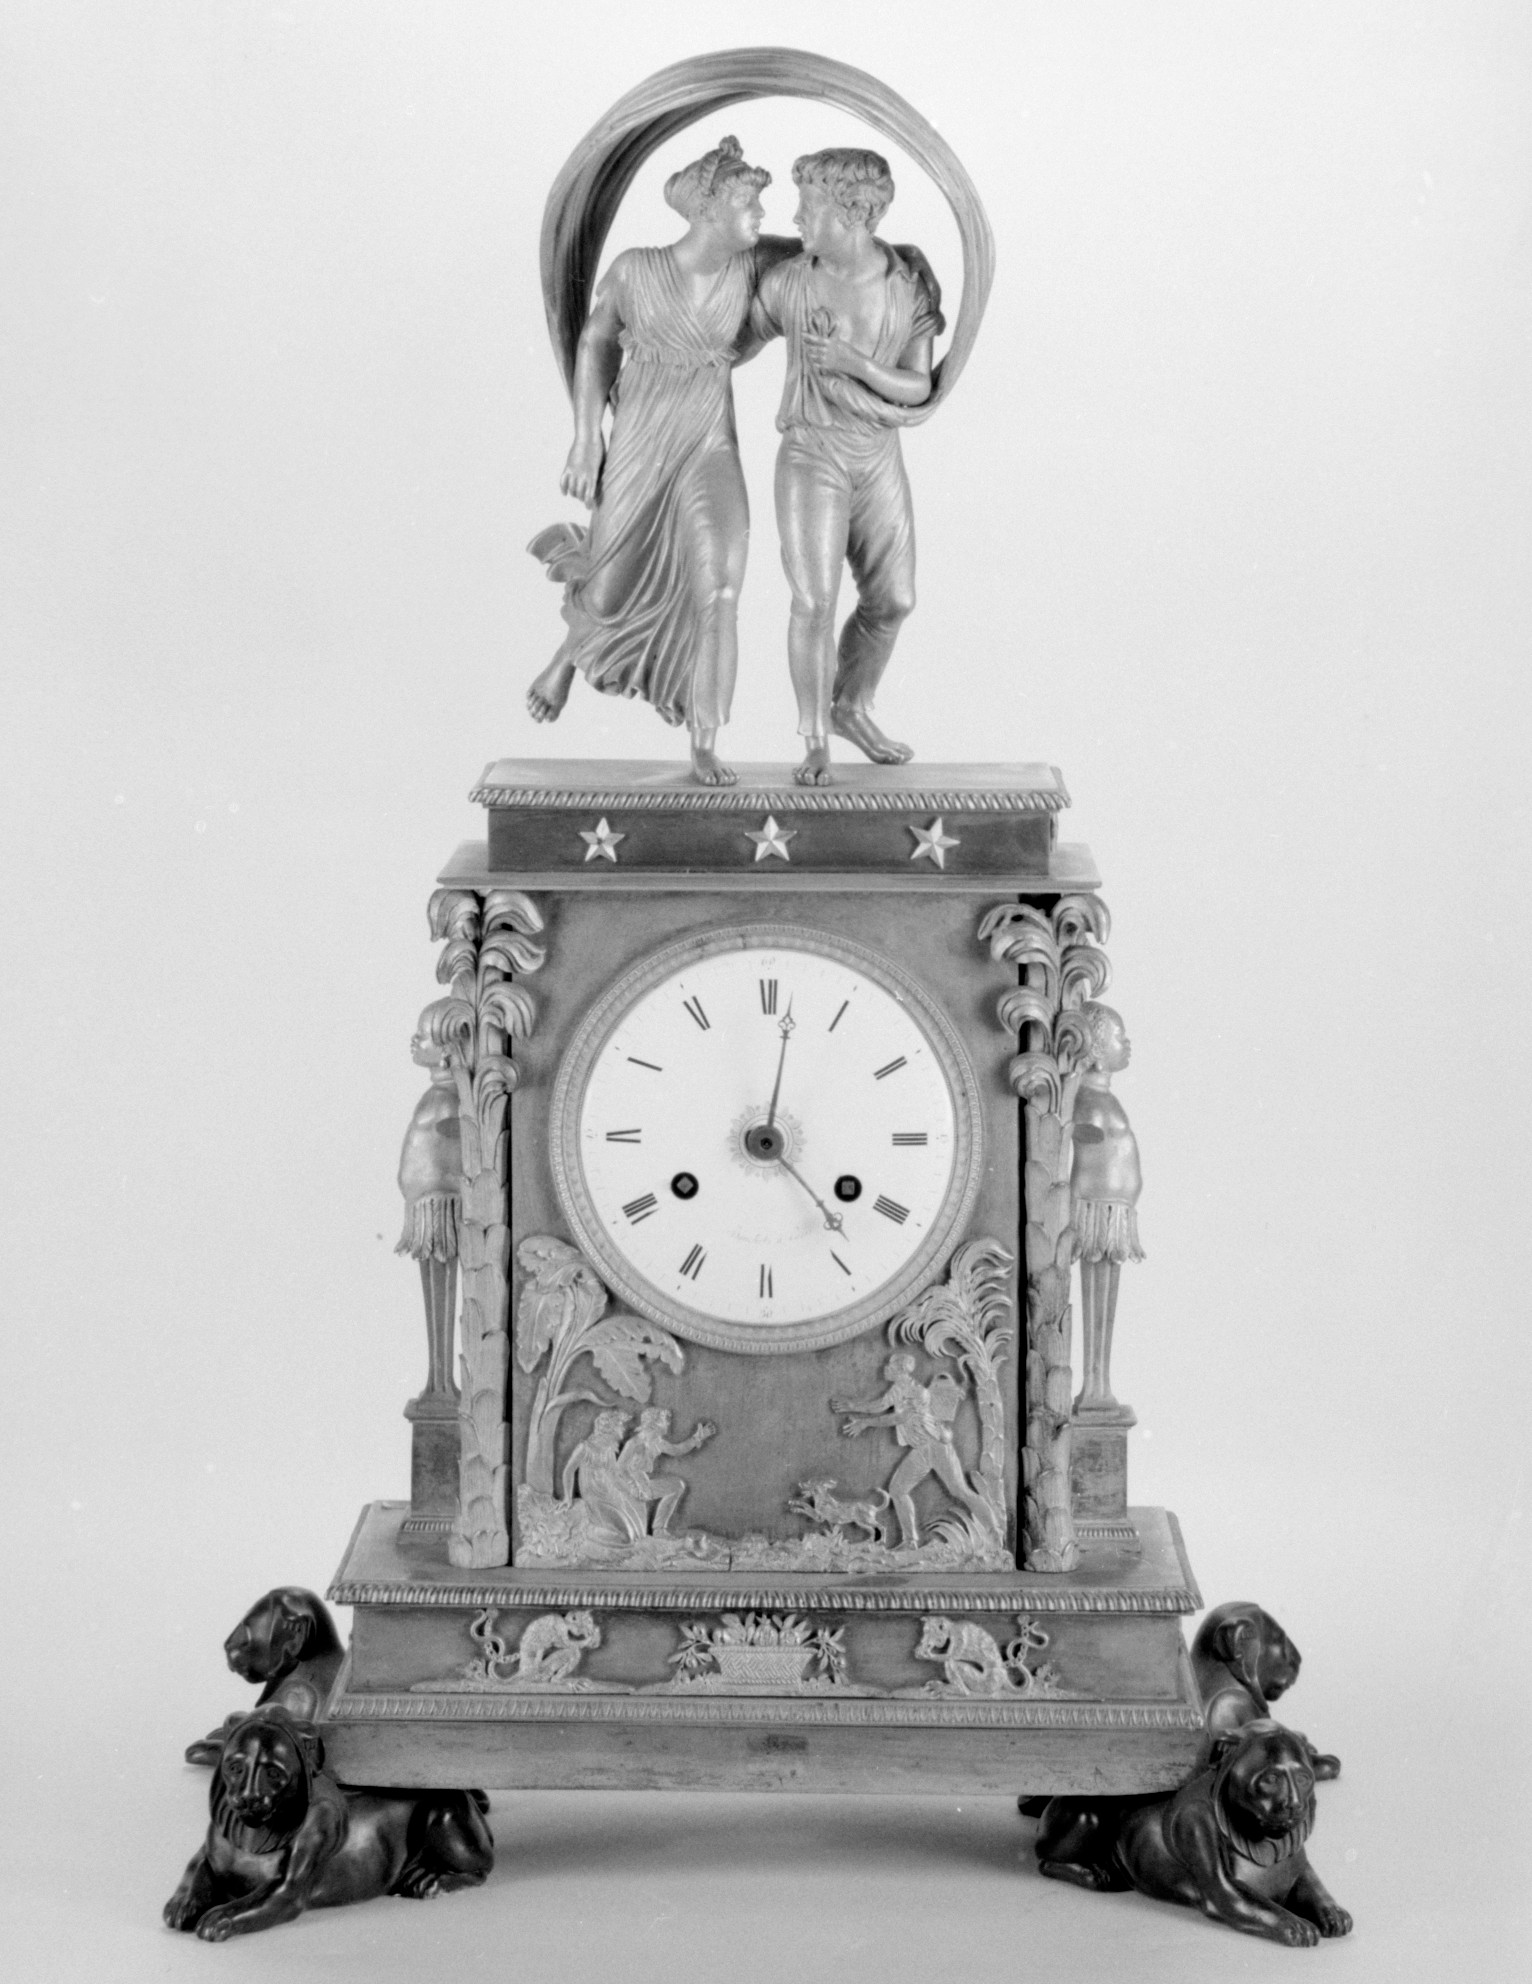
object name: clock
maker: bouchet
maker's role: maker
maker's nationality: french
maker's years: 1775-1875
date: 1801-1833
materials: gilt bronze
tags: animals,men,women